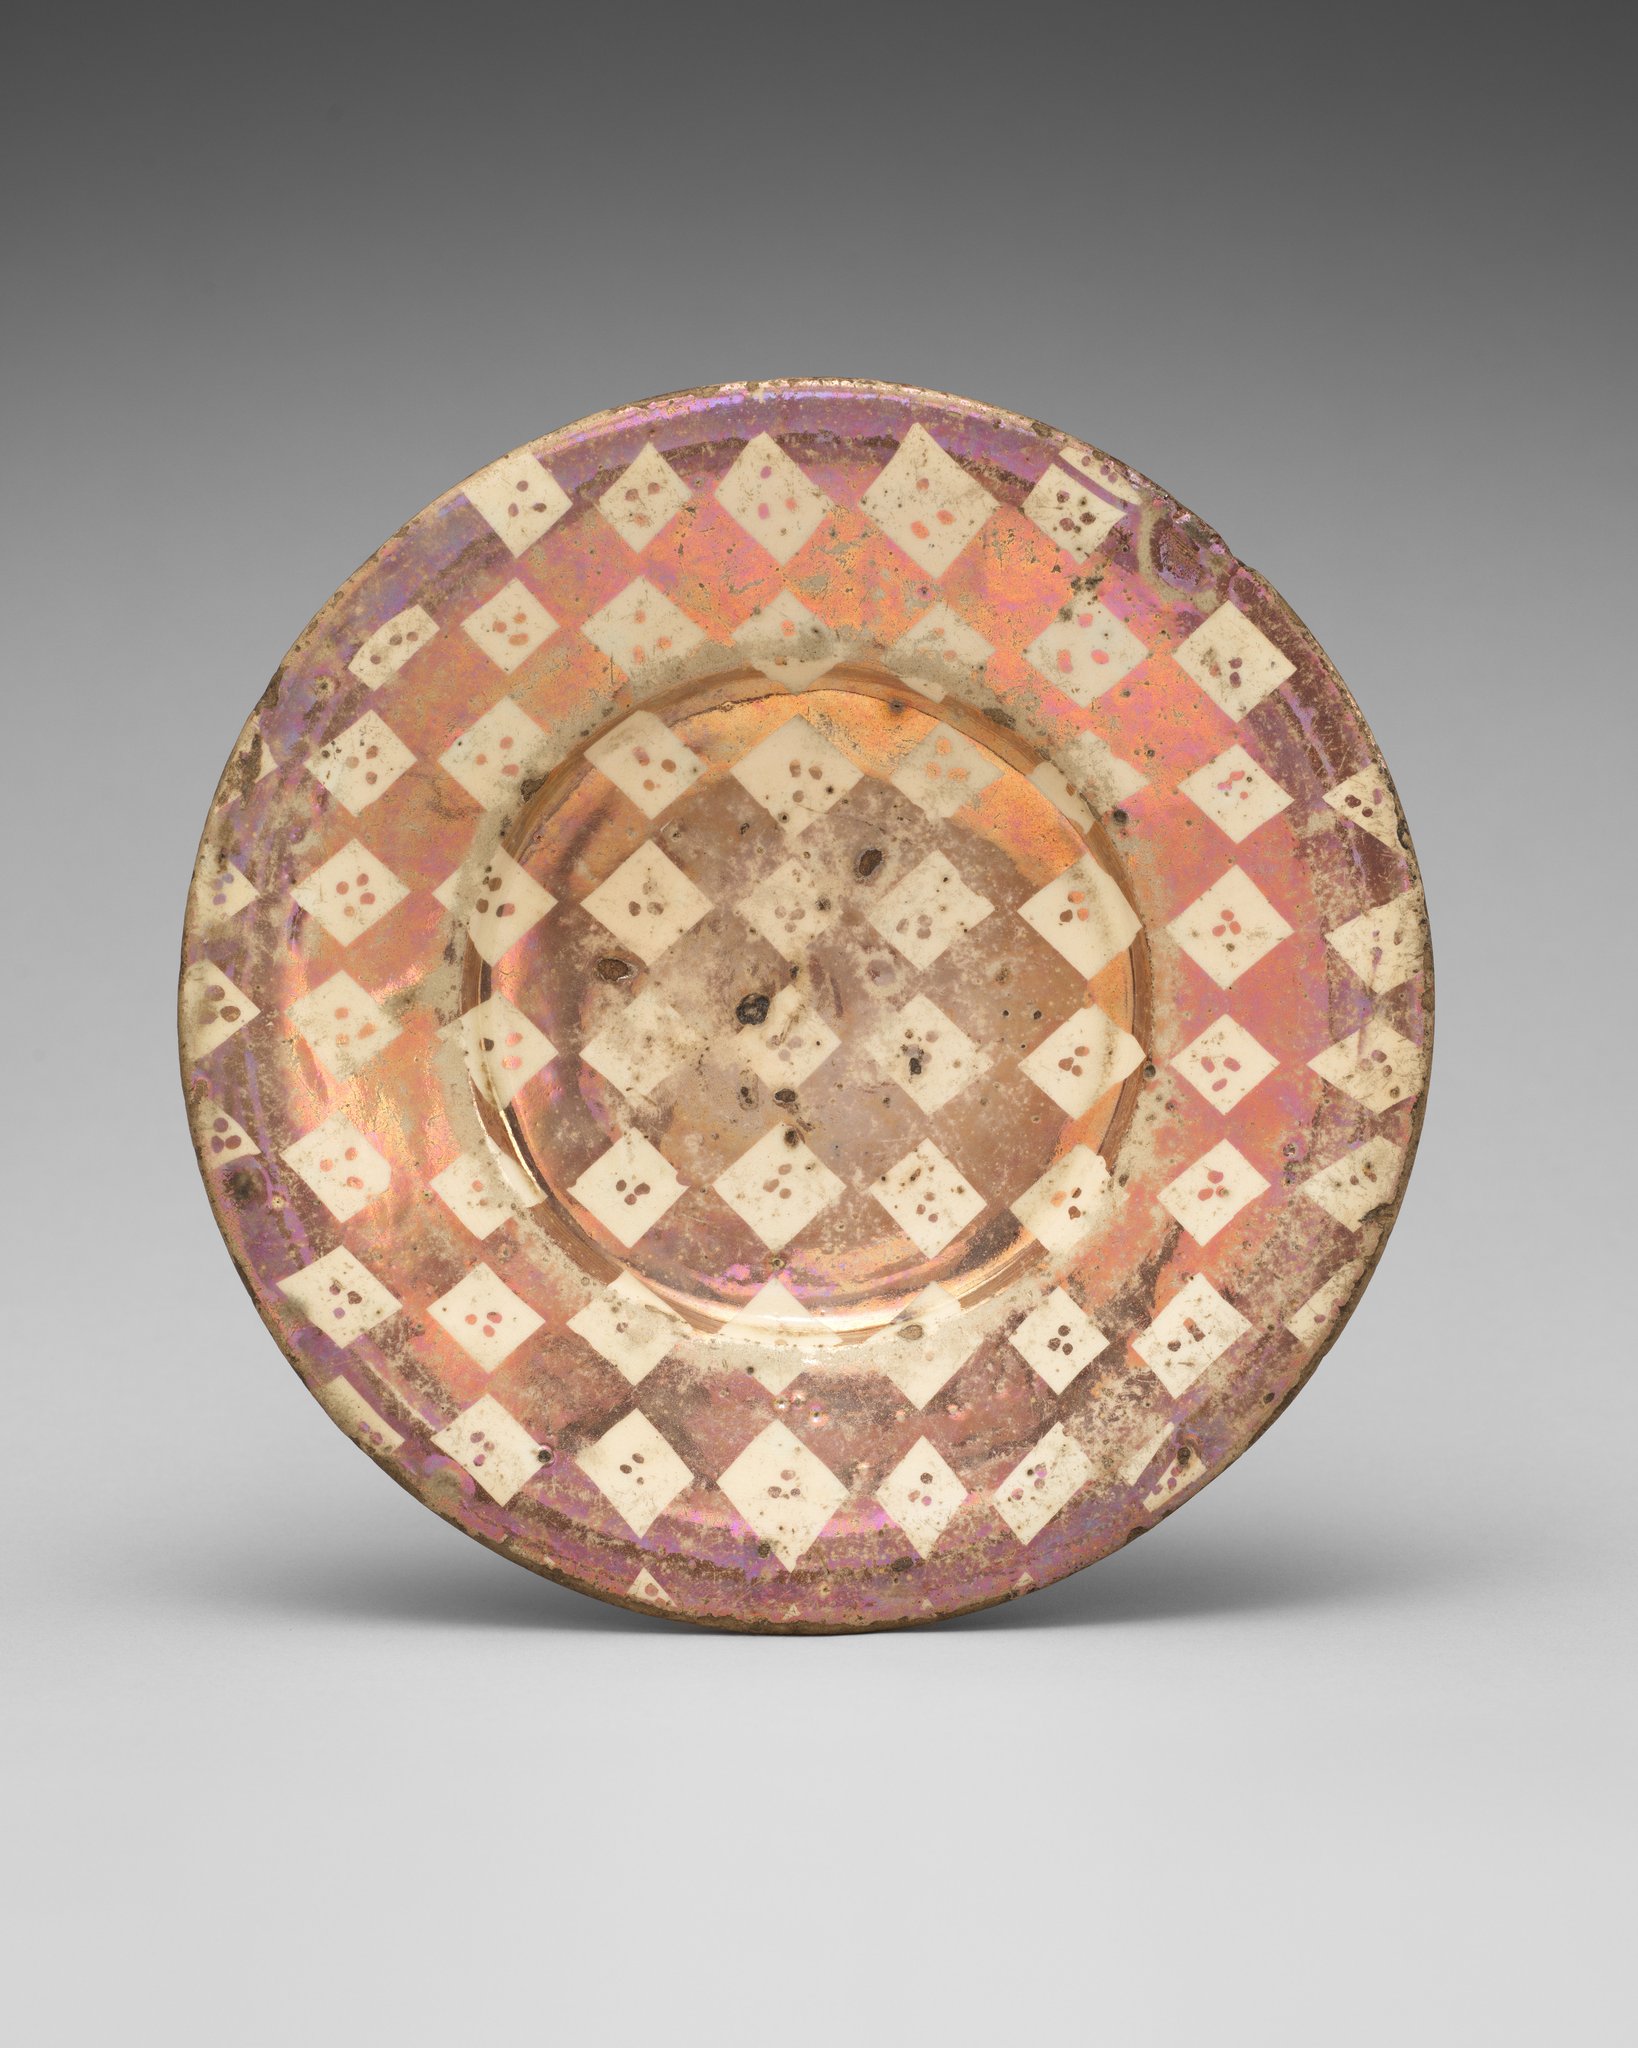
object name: plate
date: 1601-1633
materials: earthenware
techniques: luster painting, glazing